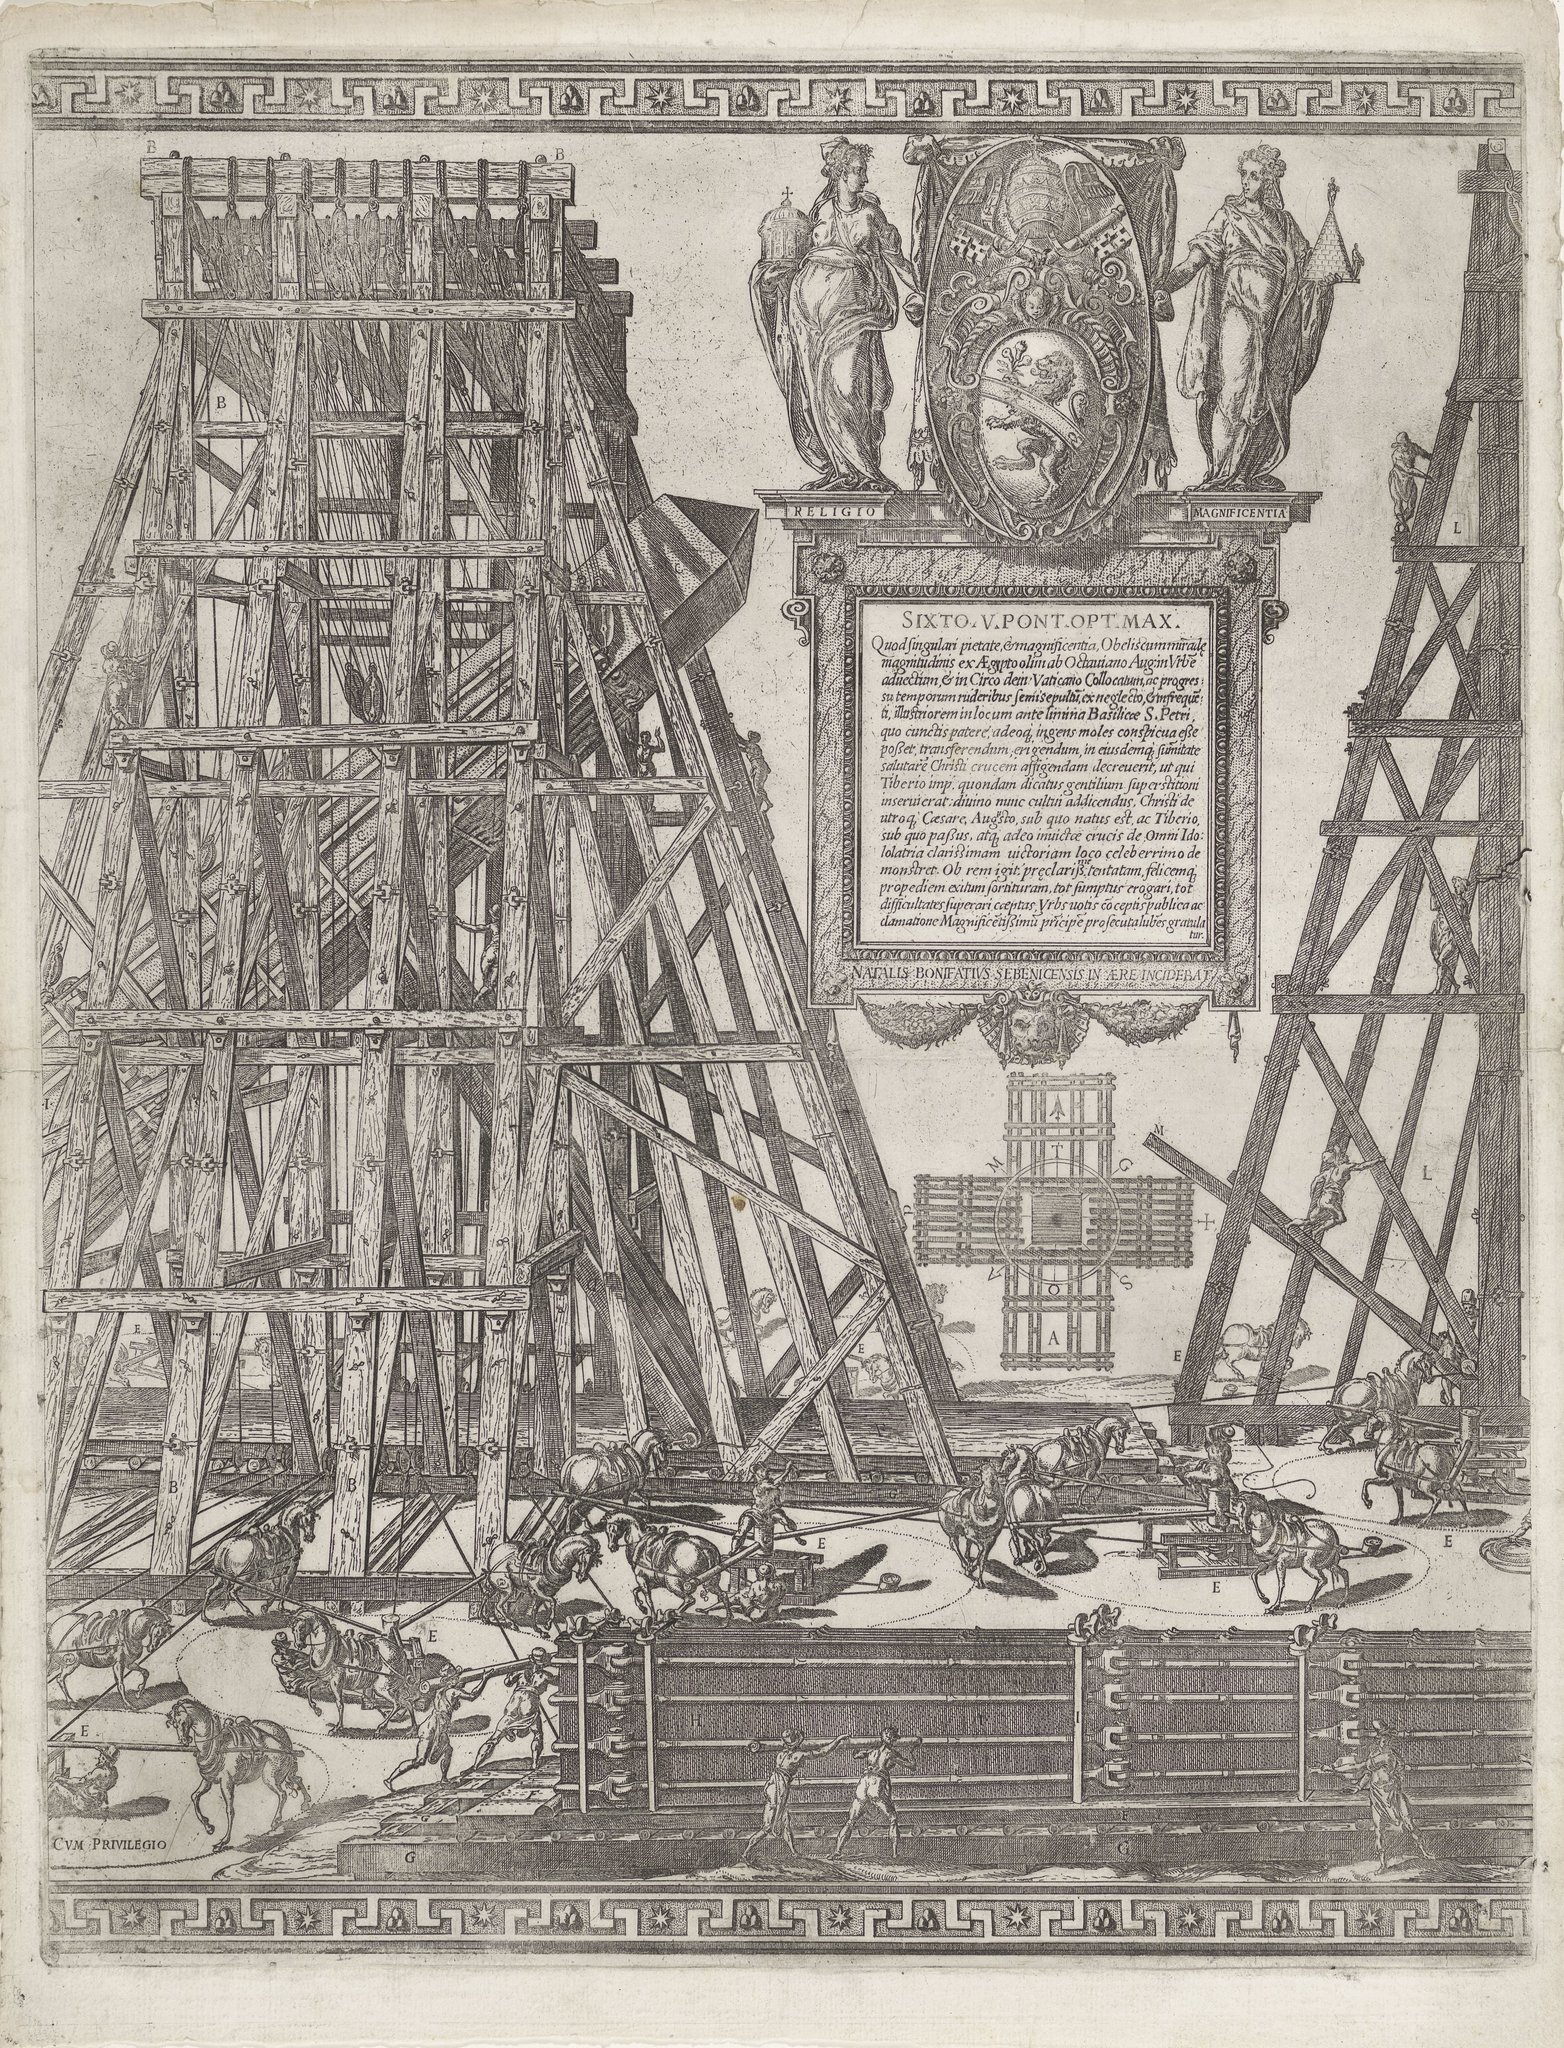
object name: print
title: Het oprichten van de obelisk op het St. Pietersplein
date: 1586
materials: paper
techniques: etching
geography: rome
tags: rome, sixtus v, switzerland, naples, domenico fontana, obelisk, needle, roman catholic church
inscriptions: collector's mark: Lugt 2228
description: Mannen en paarden zijn bezig met het oprichten van de Vaticaanse Obelisk (in 1586) op het St. Pietersplein, met behulp van een grote houten stellage. Rechtsboven een sierlijst met tekst, het wapen van Paus Sixtus V en personificaties van Religie en Grootsheid. Rechtsonder mannen die de obelisk transporteren met behulp van ronde palen. Voorstelling is gevat in een sierlijst.